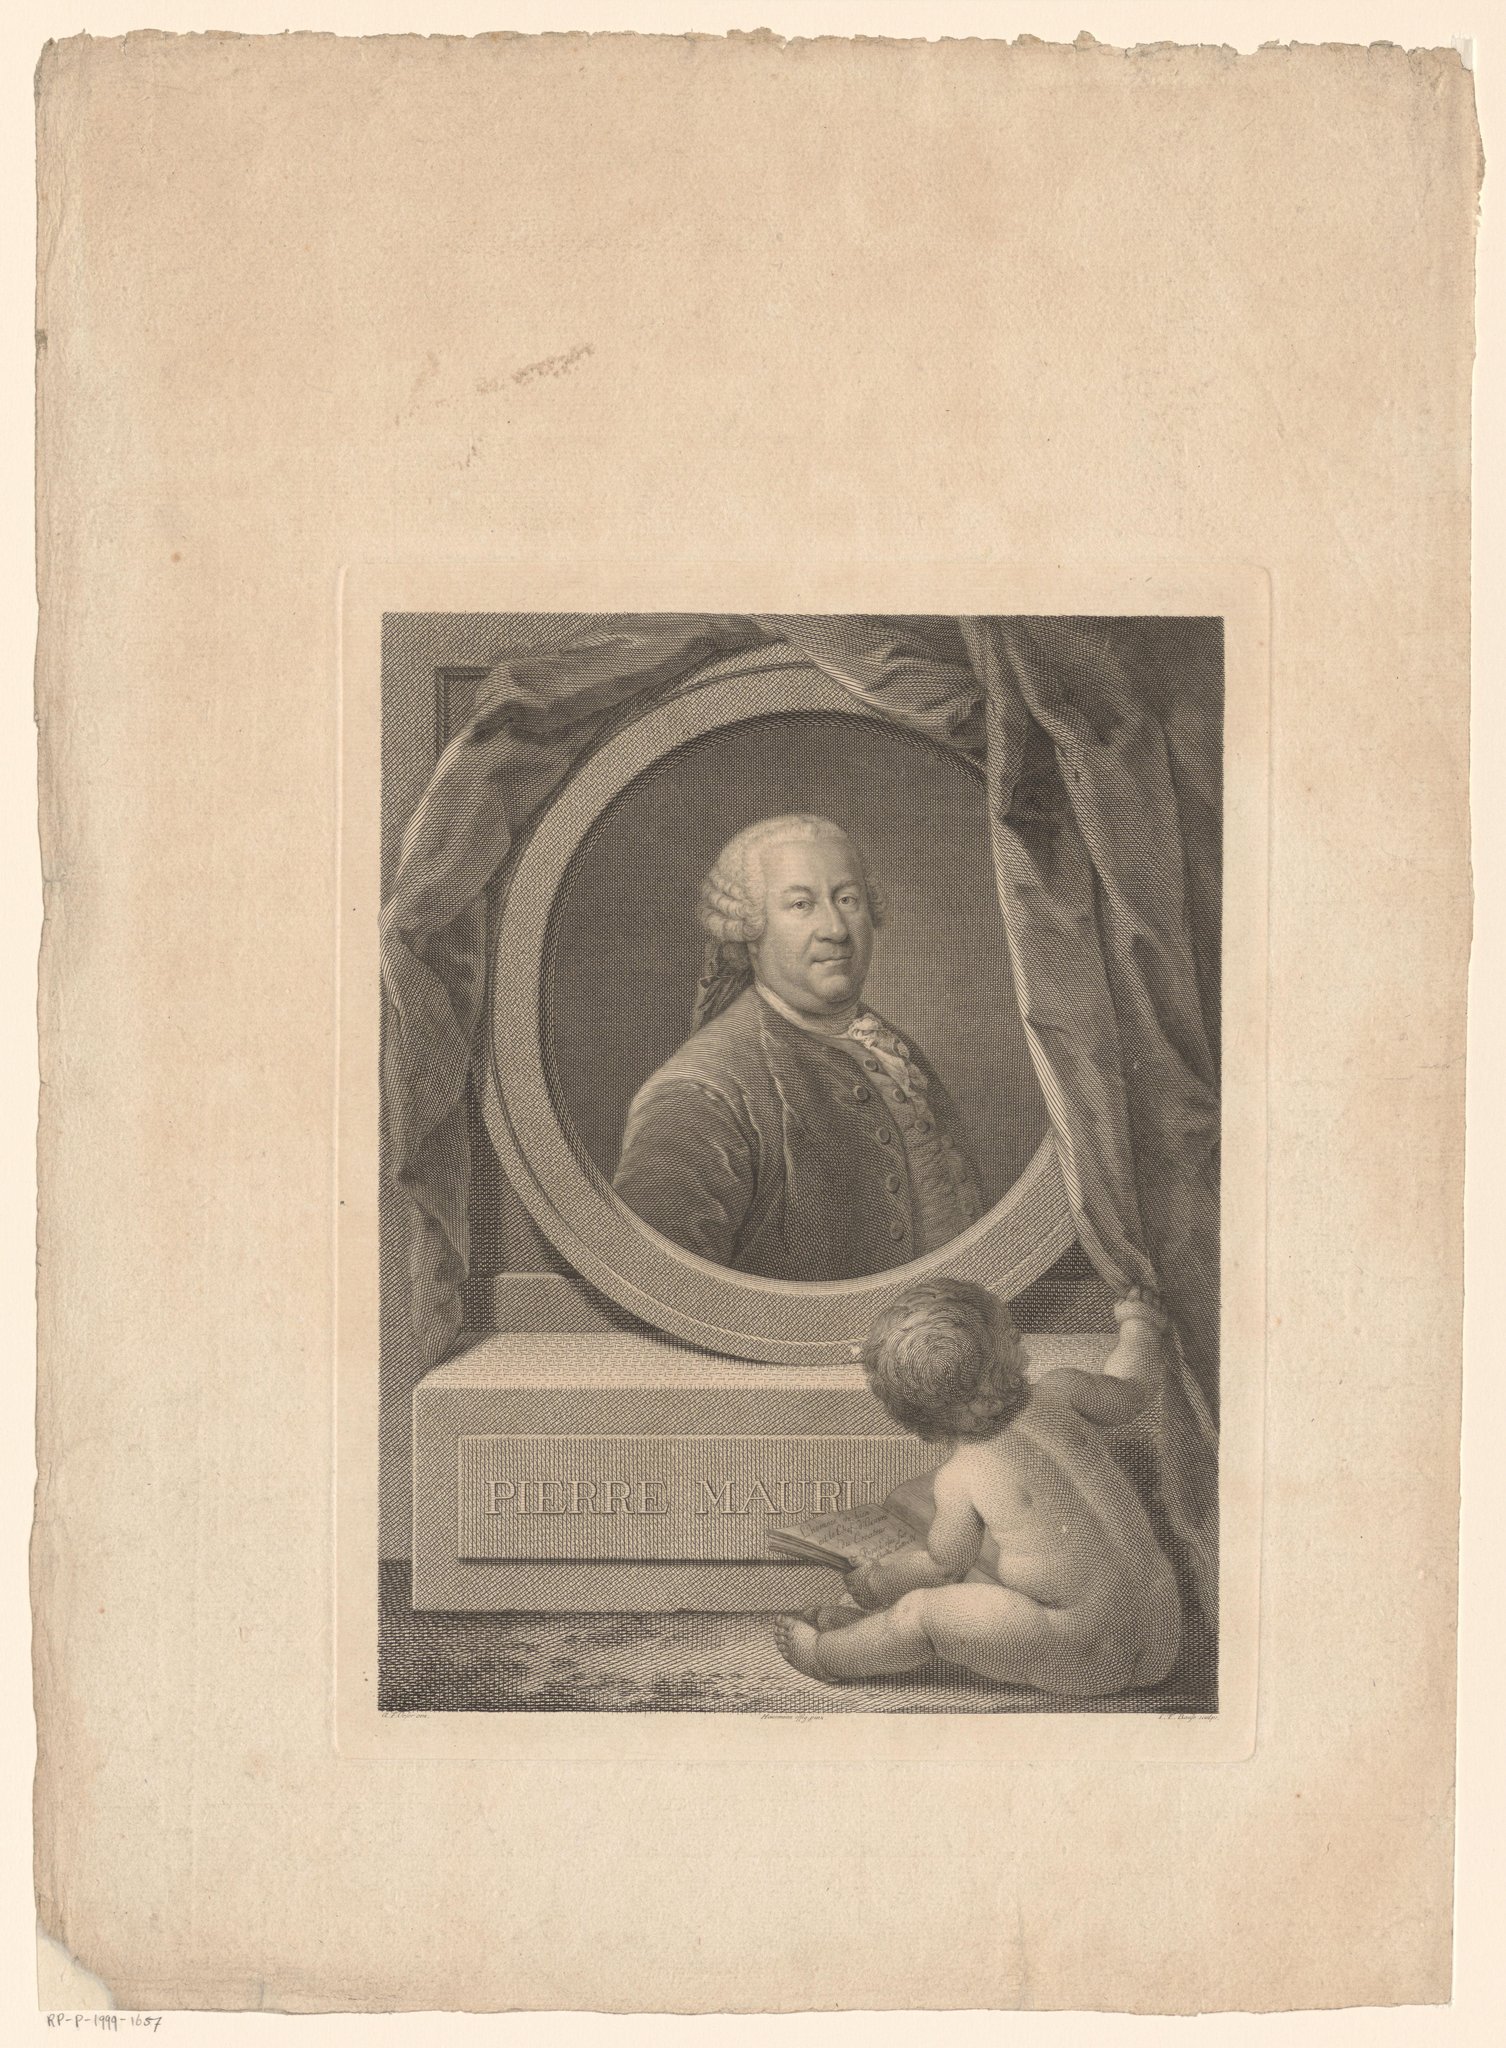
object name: print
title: Portret van Peter Mauru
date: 1771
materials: paper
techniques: engraving, etching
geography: leipzig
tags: ornament ~ medallion, historical persons, book - mm - book open, cupids: 'amores', 'amoretti', 'putti'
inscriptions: collector's mark: Lugt 2228